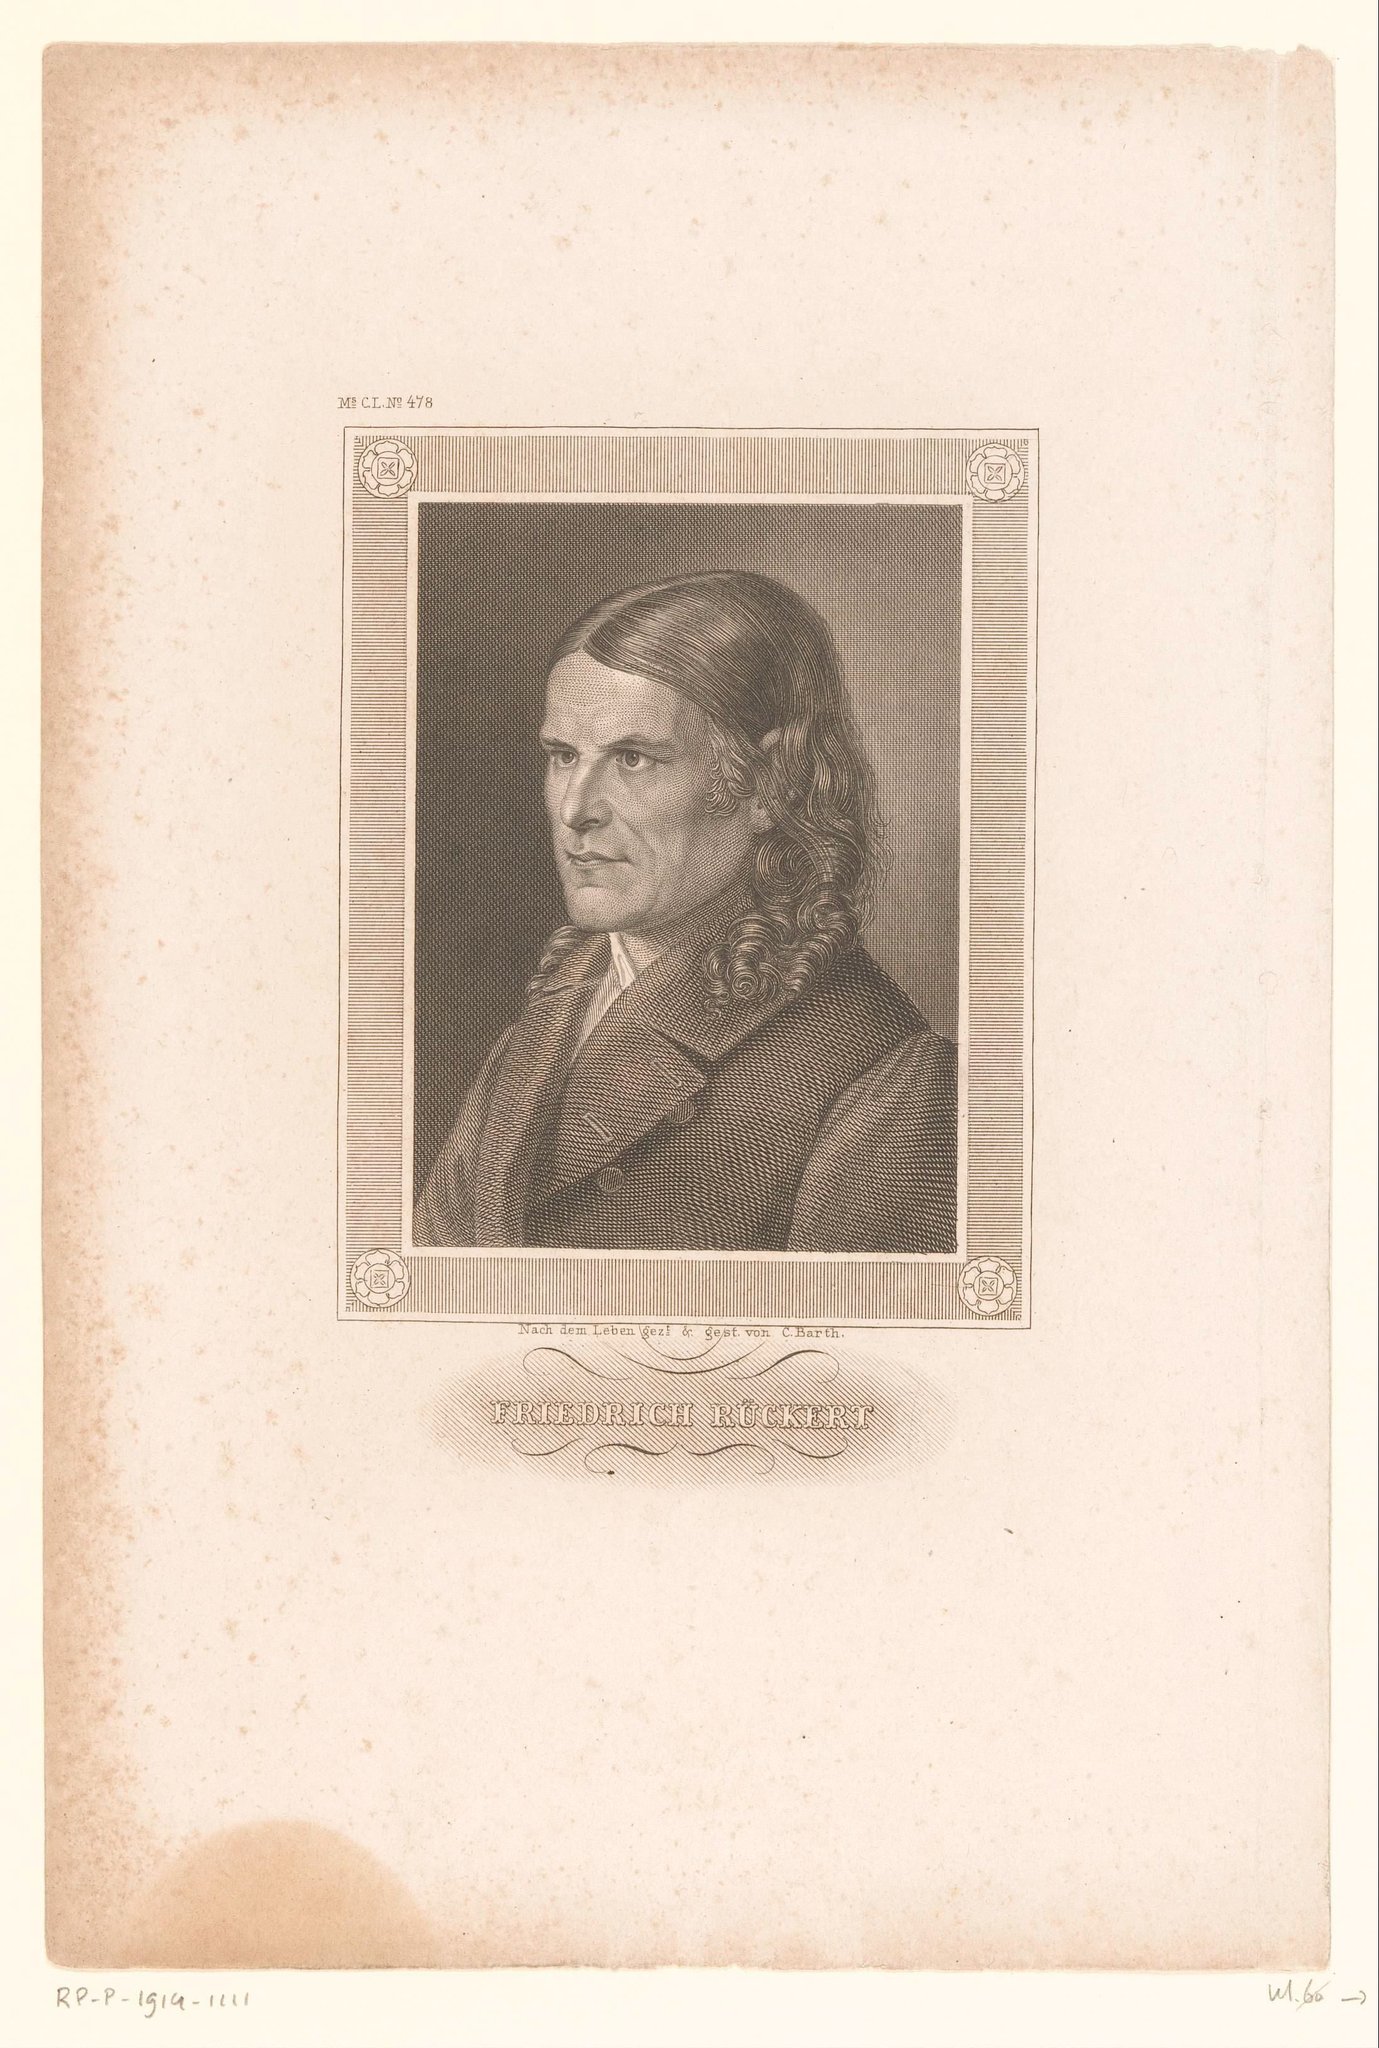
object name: print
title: Portret van Friedrich Rückert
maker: karl barth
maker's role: print maker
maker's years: 1787-1853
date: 1828-1853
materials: paper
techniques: engraving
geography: hildburghausen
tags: friedrich rückert, historical persons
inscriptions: collector's mark: Lugt 2228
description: Prent afkomstig uit: Meyer, Joseph. Das große Conversations-Lexikon für die gebildeten Stände.